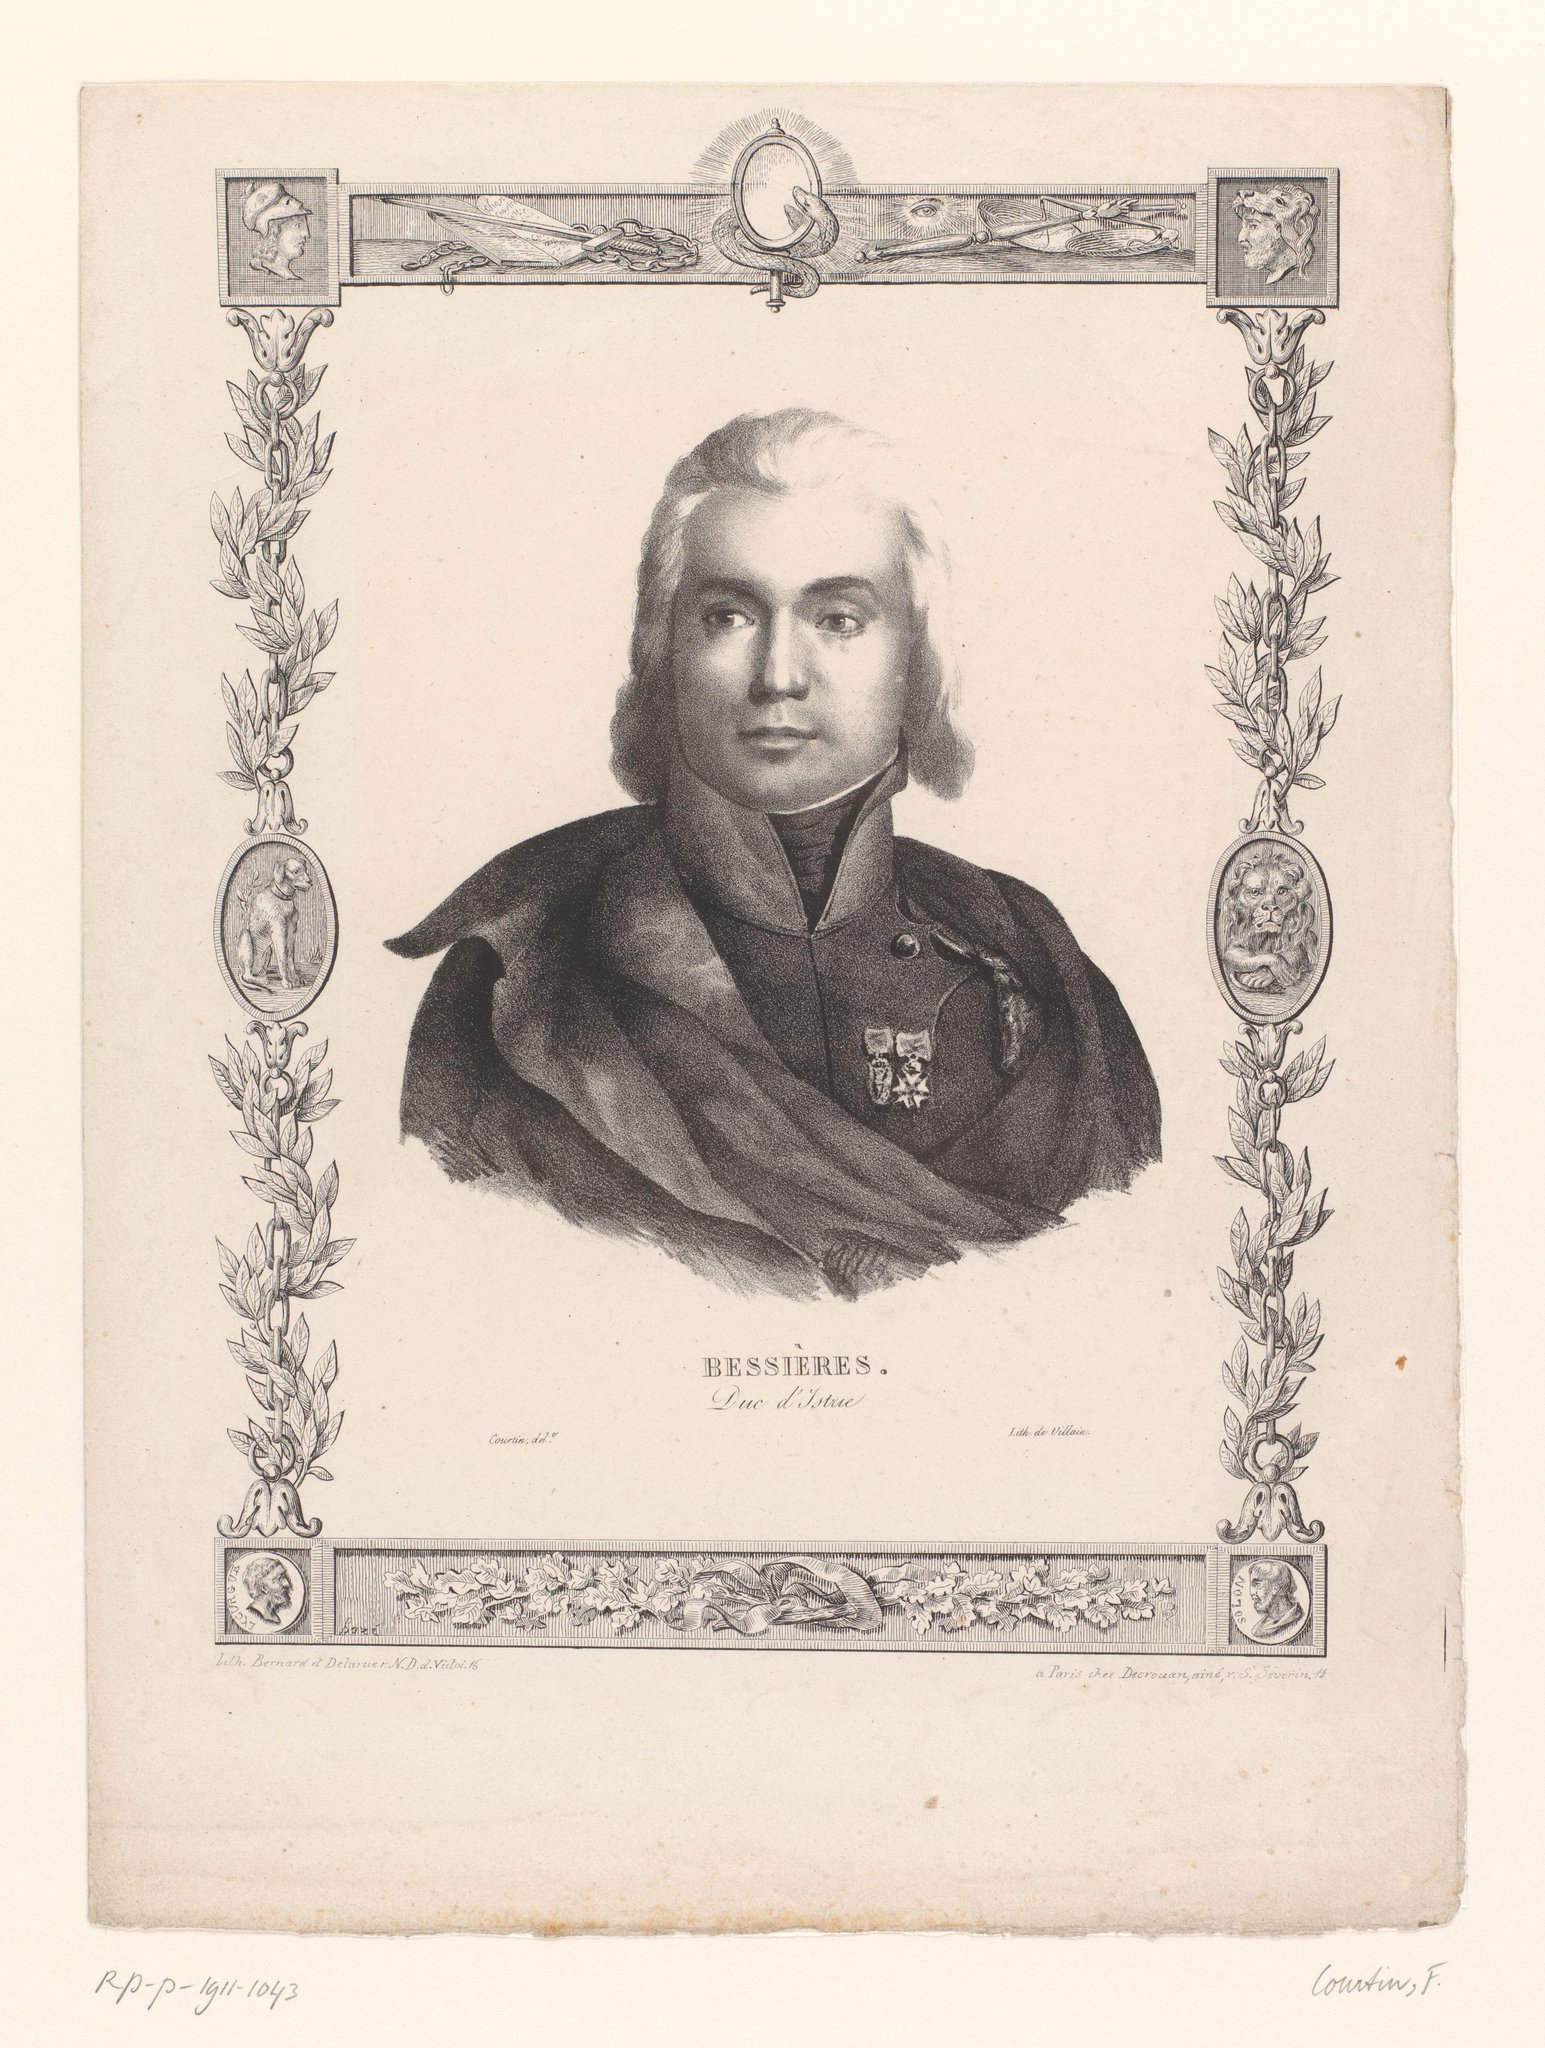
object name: print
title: Bessières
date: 1829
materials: paper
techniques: lithograph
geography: paris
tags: historical persons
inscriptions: collector's mark: Lugt 2228a